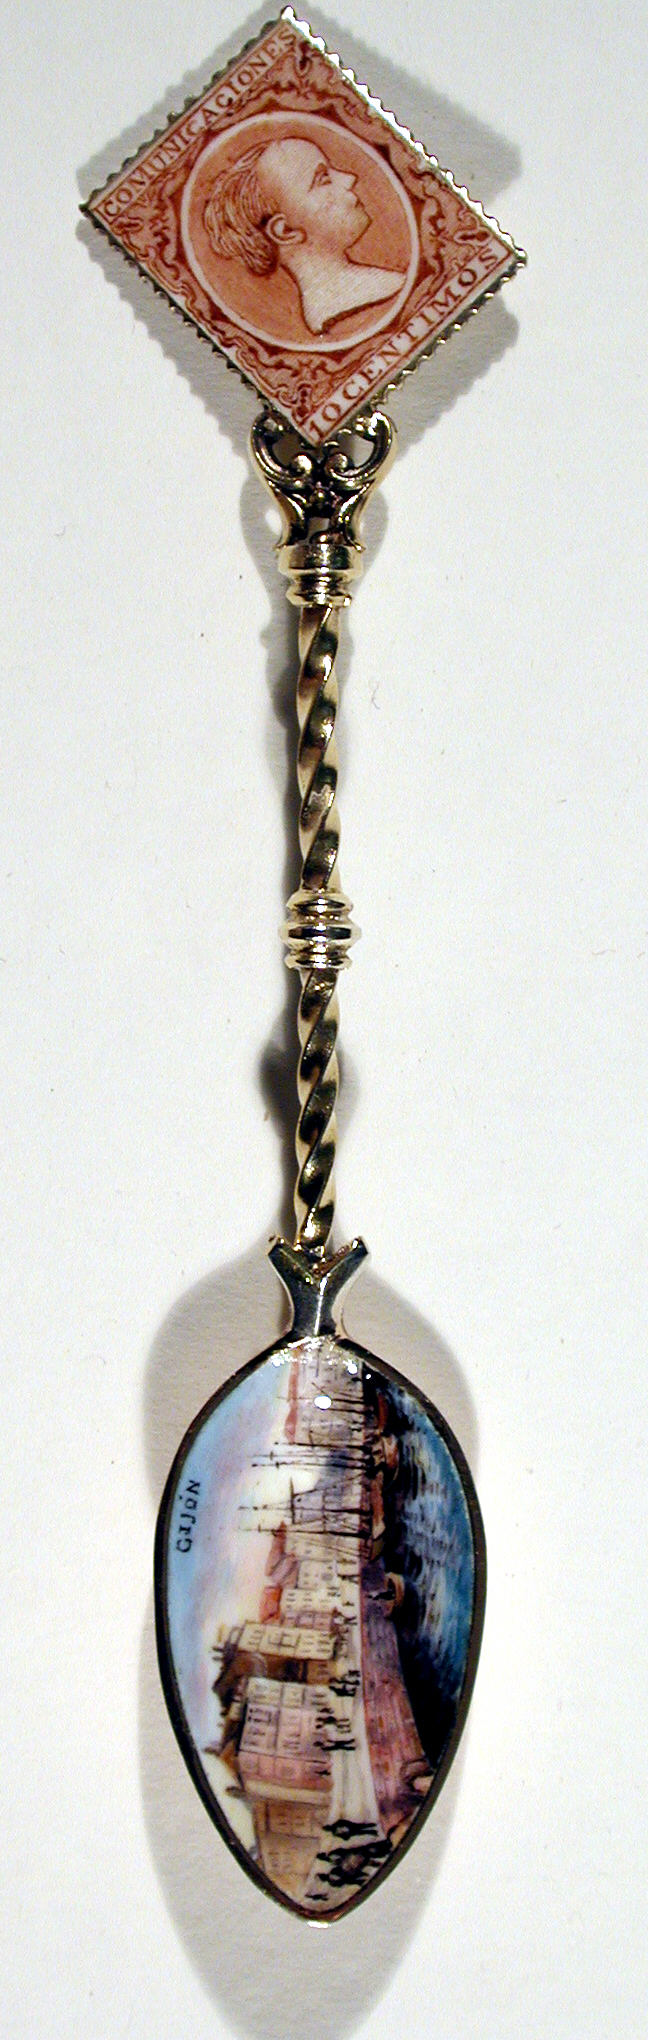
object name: souvenir spoon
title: Souvenir spoon with view of a harbor and finial in form of a postage stamp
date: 1867-1900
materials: enamel, gilt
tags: buildings,boats